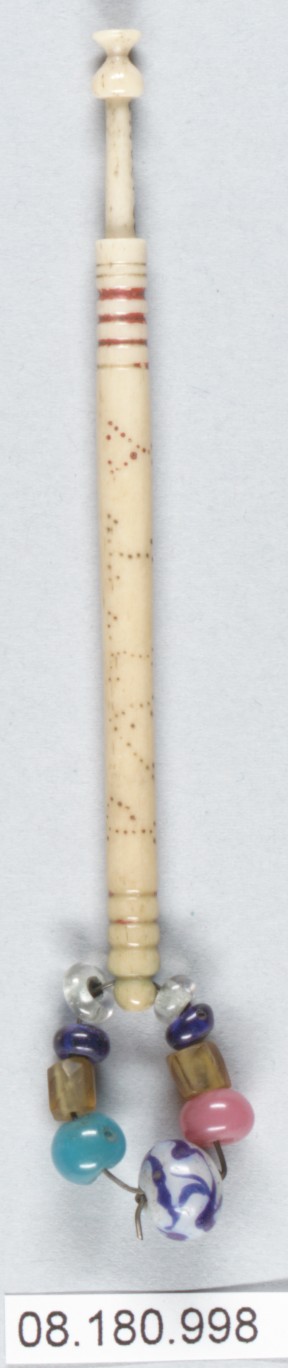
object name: bobbin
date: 1801-1900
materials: bone